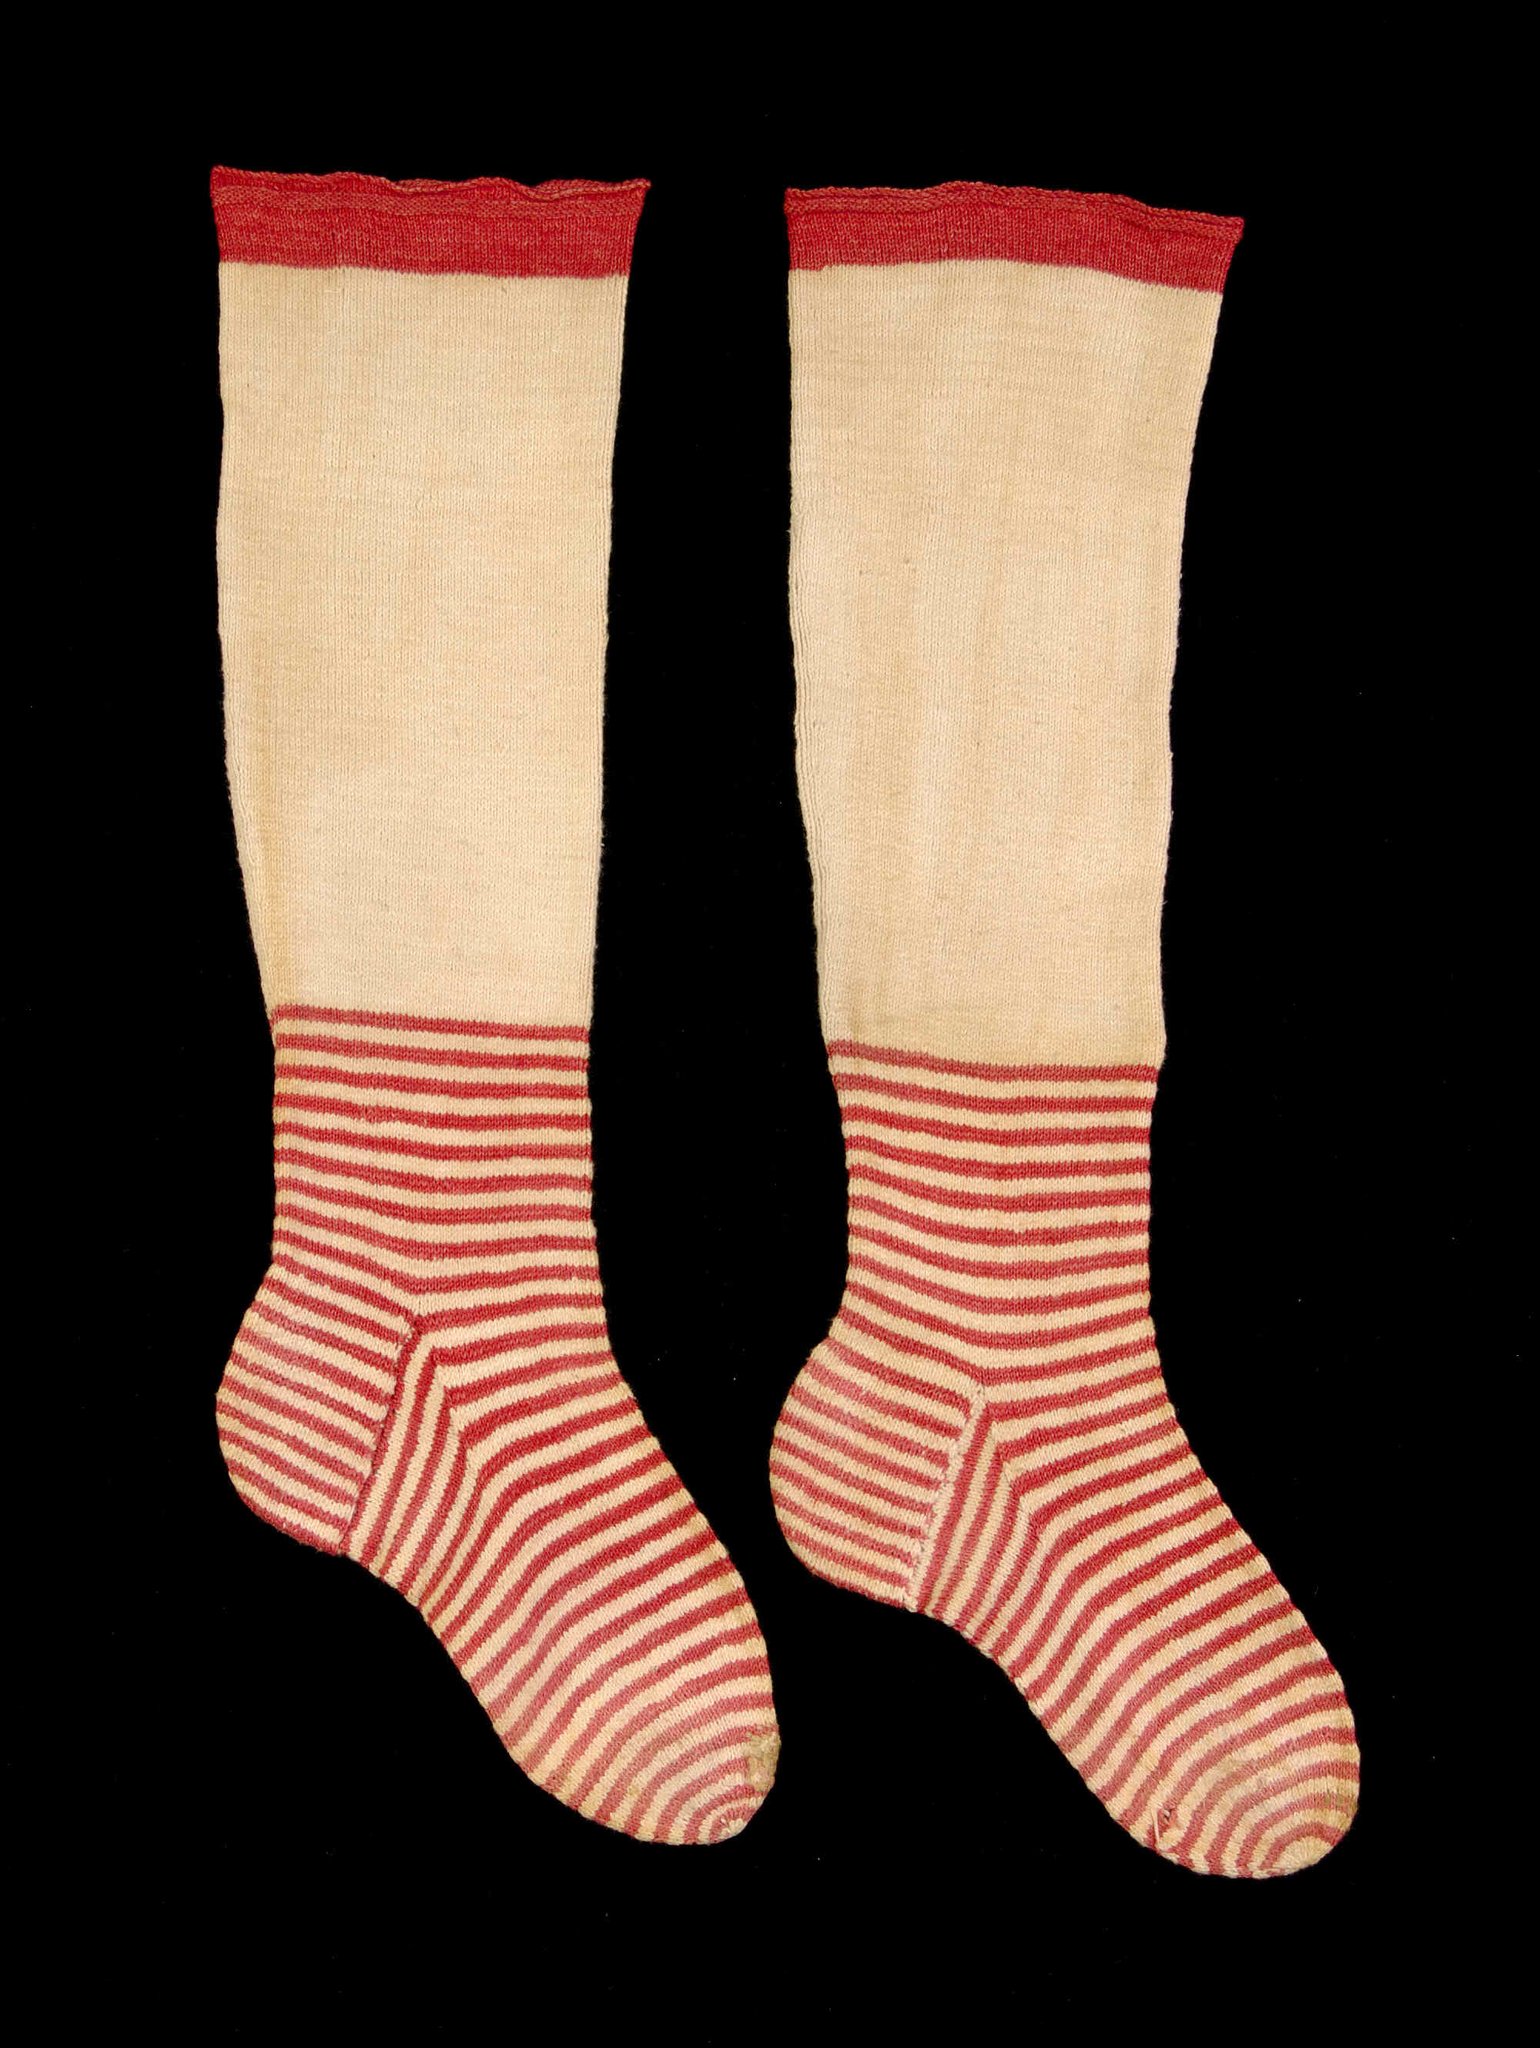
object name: stocking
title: Stockings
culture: american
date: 1860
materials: cotton